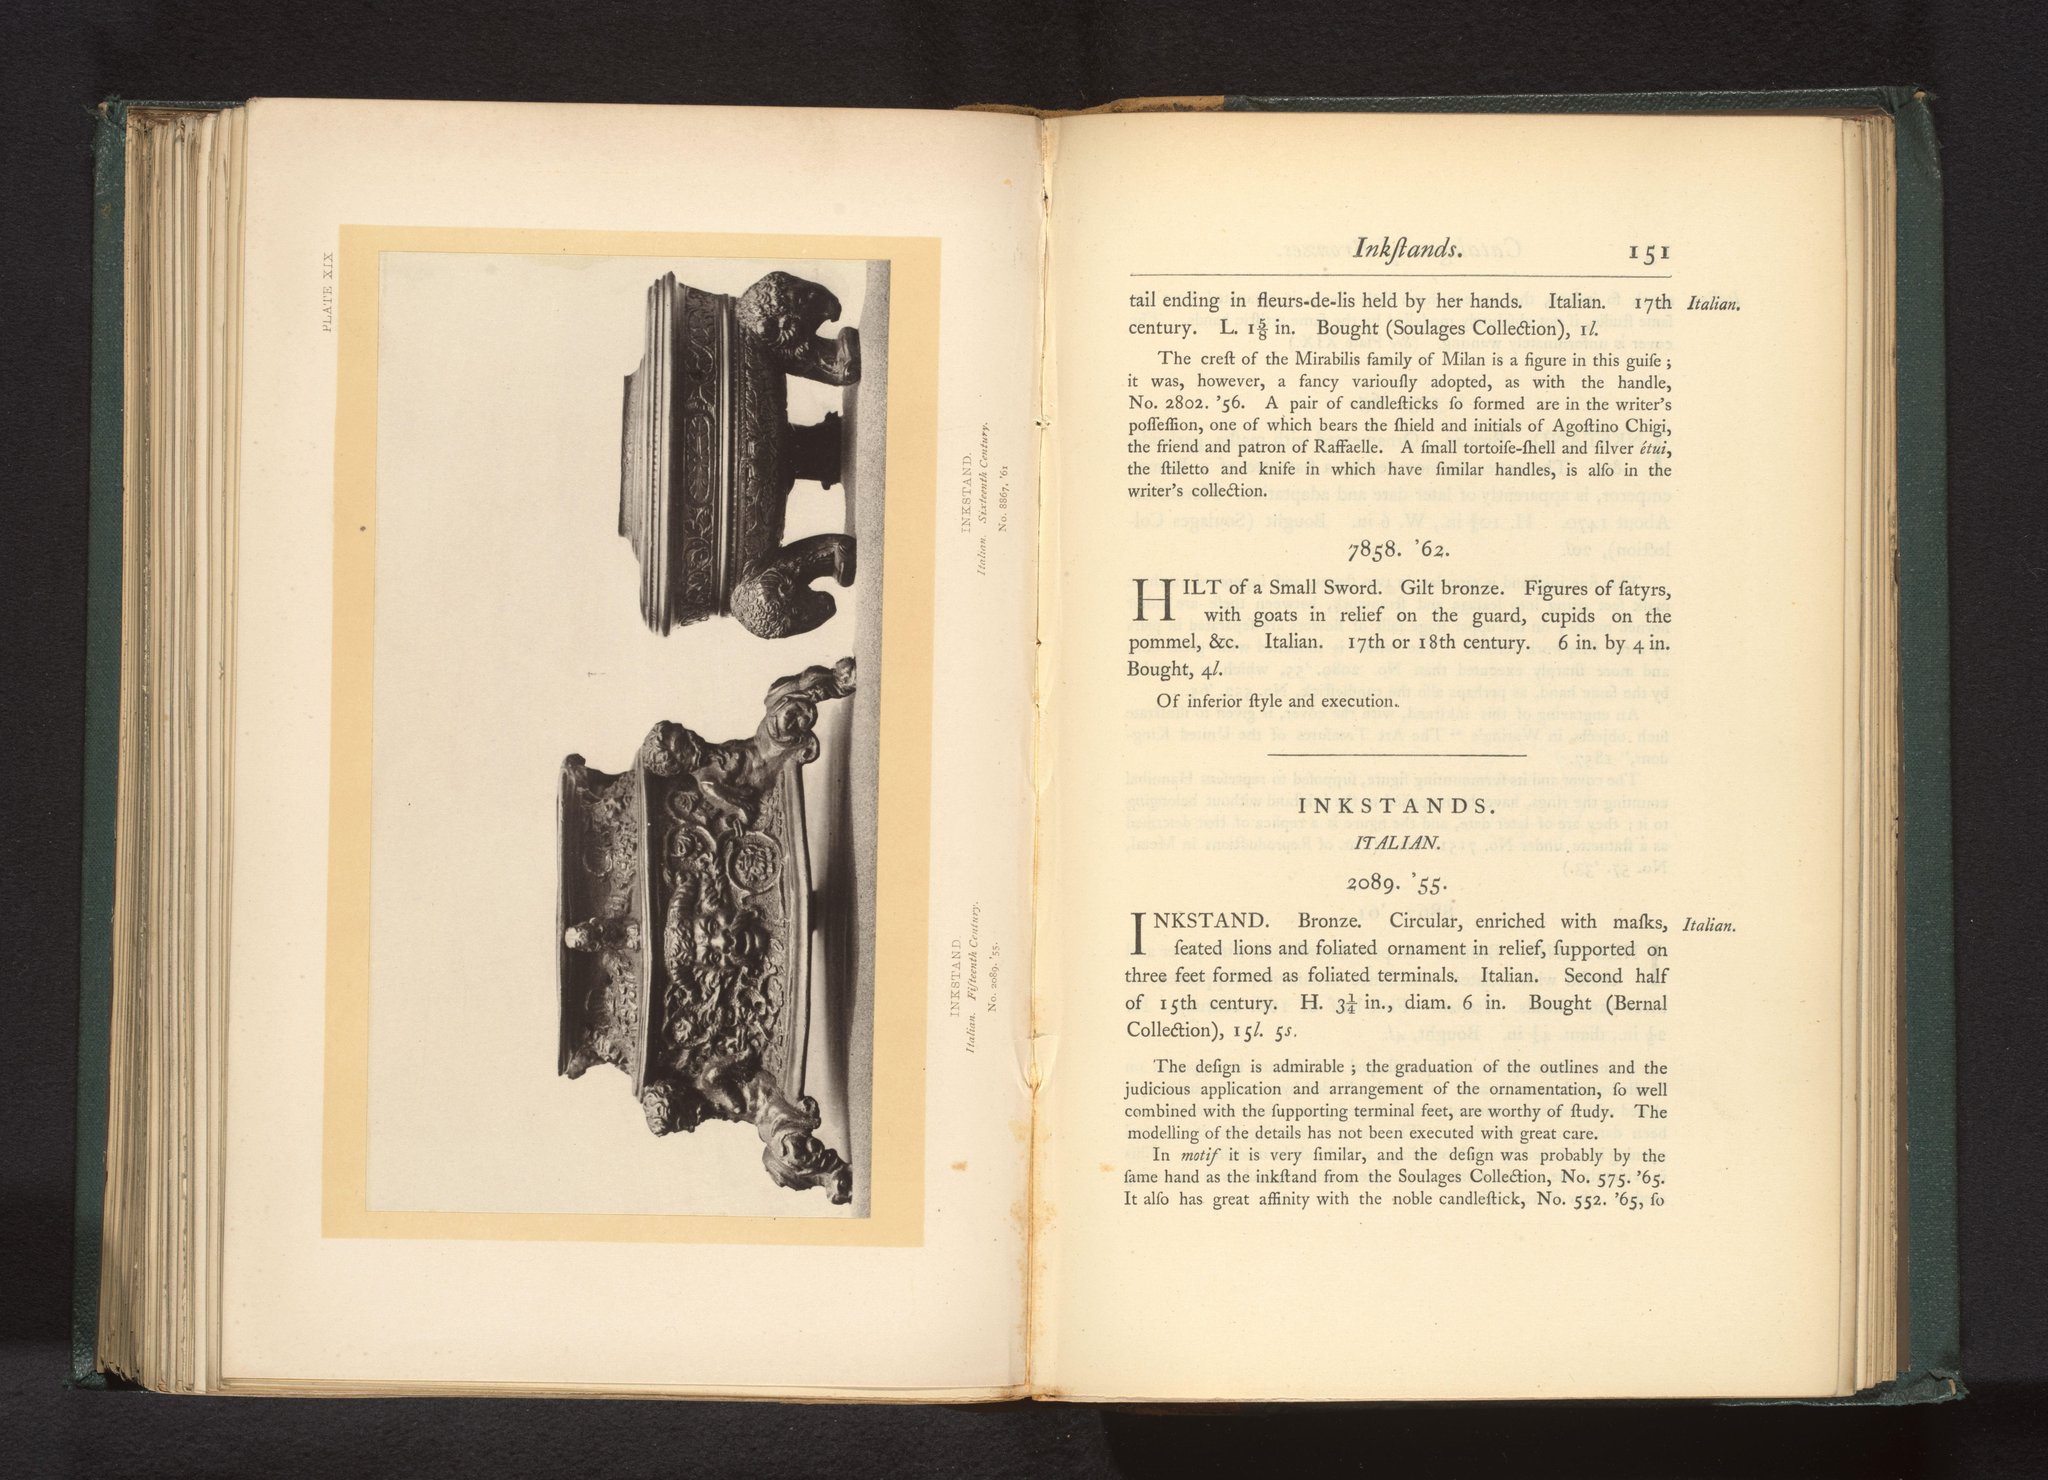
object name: page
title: Twee bronzen inktpotten in het South Kensington Museum te Londen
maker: Anonymous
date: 1869-1876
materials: paper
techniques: woodburytype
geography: london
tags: ink-well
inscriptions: number: ‘Plate XIX.’, number: ‘No. 2089. '55. (...) '61’, inscription: ‘Inkstand (...) Century.’